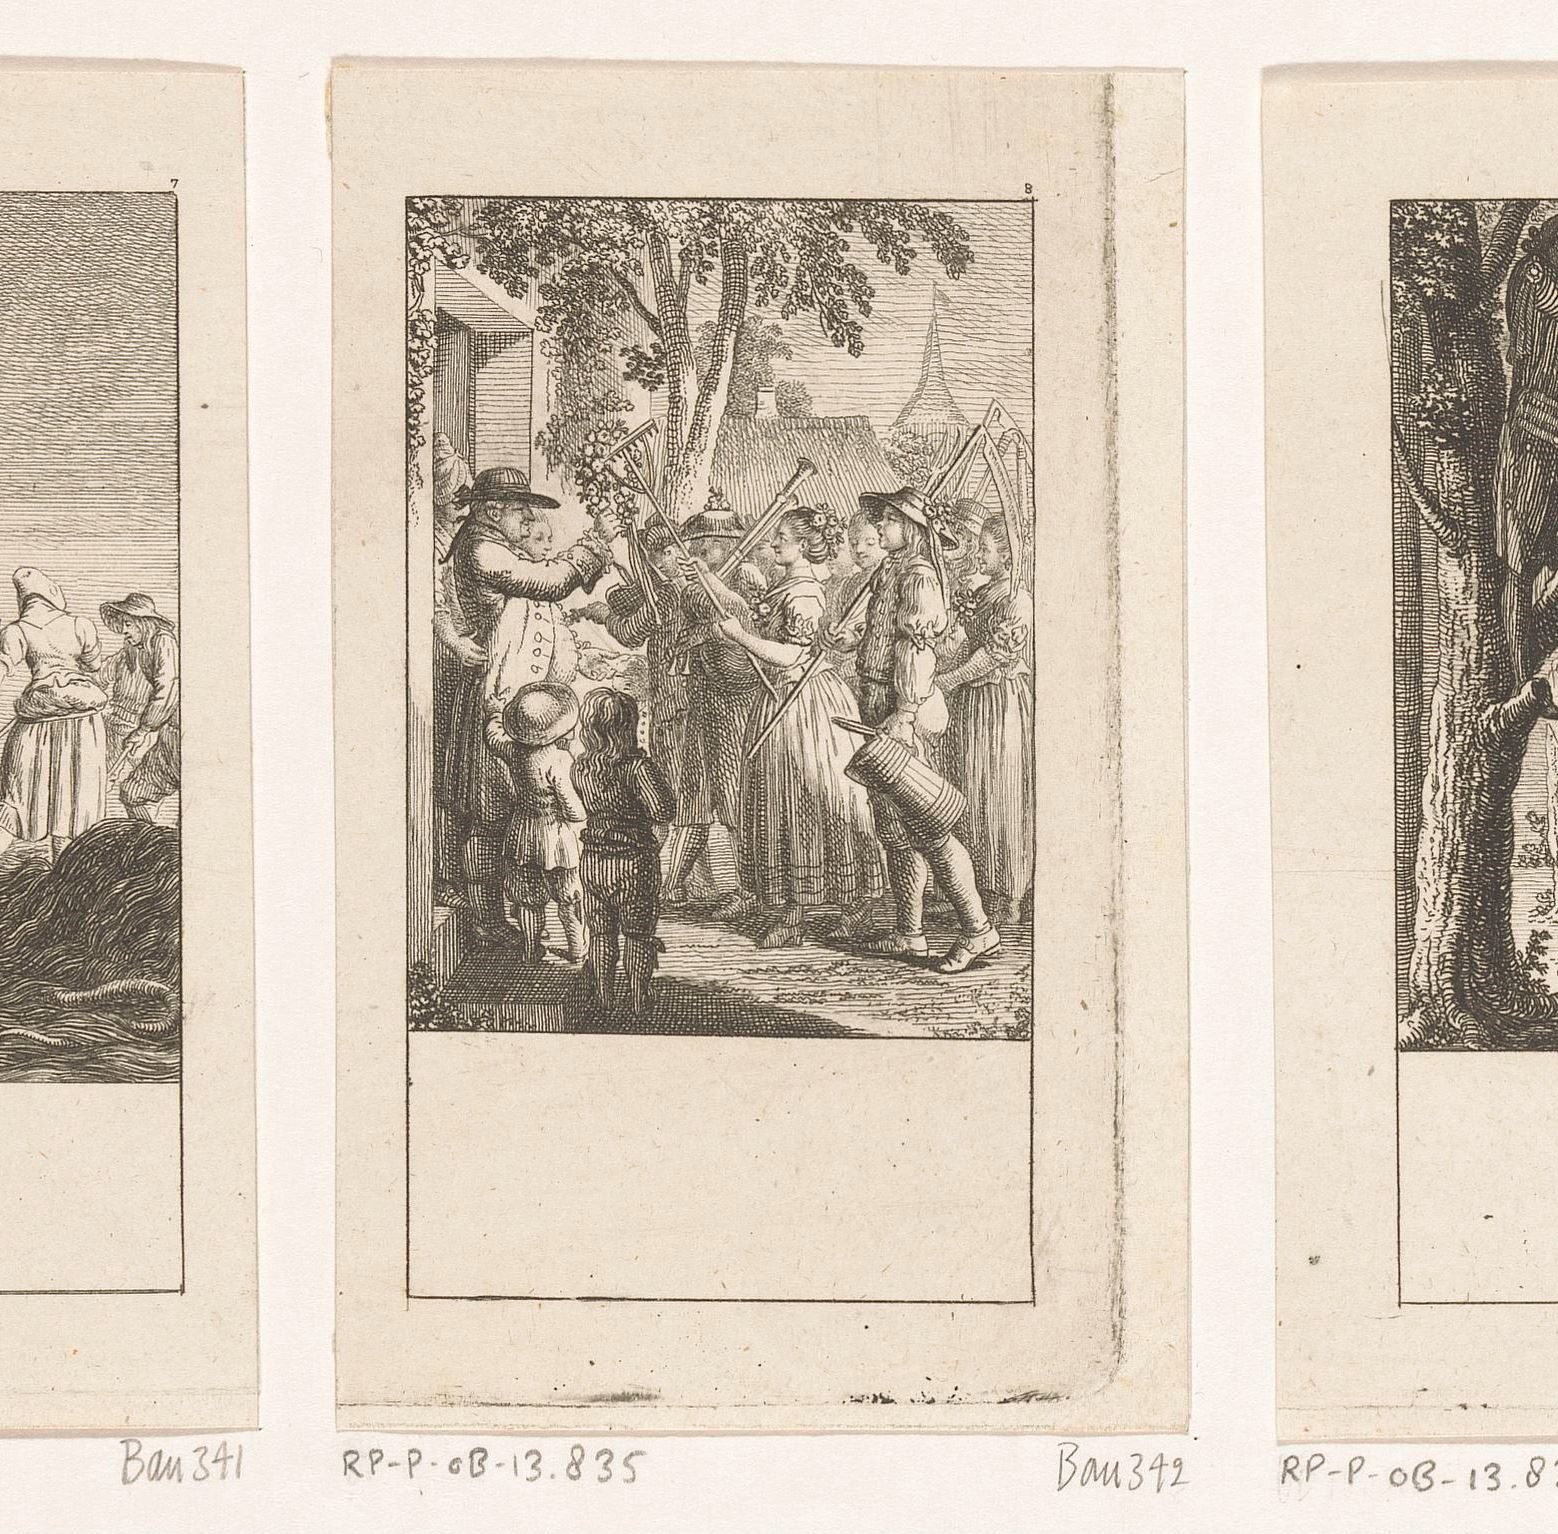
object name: print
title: Augustus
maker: daniel nikolaus chodowiecki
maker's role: draughtsman, print maker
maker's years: 1726-1801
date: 1777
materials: paper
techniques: etching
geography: berlin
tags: harvest festivities, august and its 'labours'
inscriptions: collector's mark: Lugt 2228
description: Afkomstig uit een serie met de twaalf maanden. Deze serie werd op een plaat geëtst. Een latere staat van deze serie werd gebruikt in: Königl. Großbrit. Churf. Braunschw. Lüneb. Genealogischen Kalender, auf das Jahr 1778. Lauenburg: Johann Georg Berenberg.